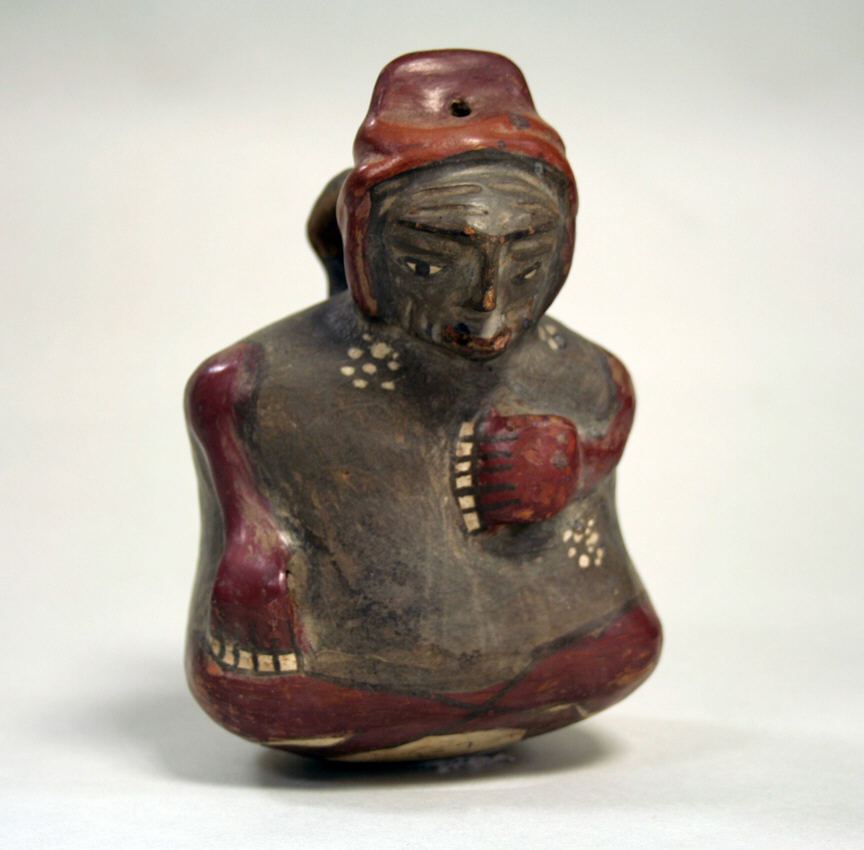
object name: bottle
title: Figure Bottle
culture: nasca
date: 601-700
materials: ceramic, pigment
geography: peru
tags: human figures